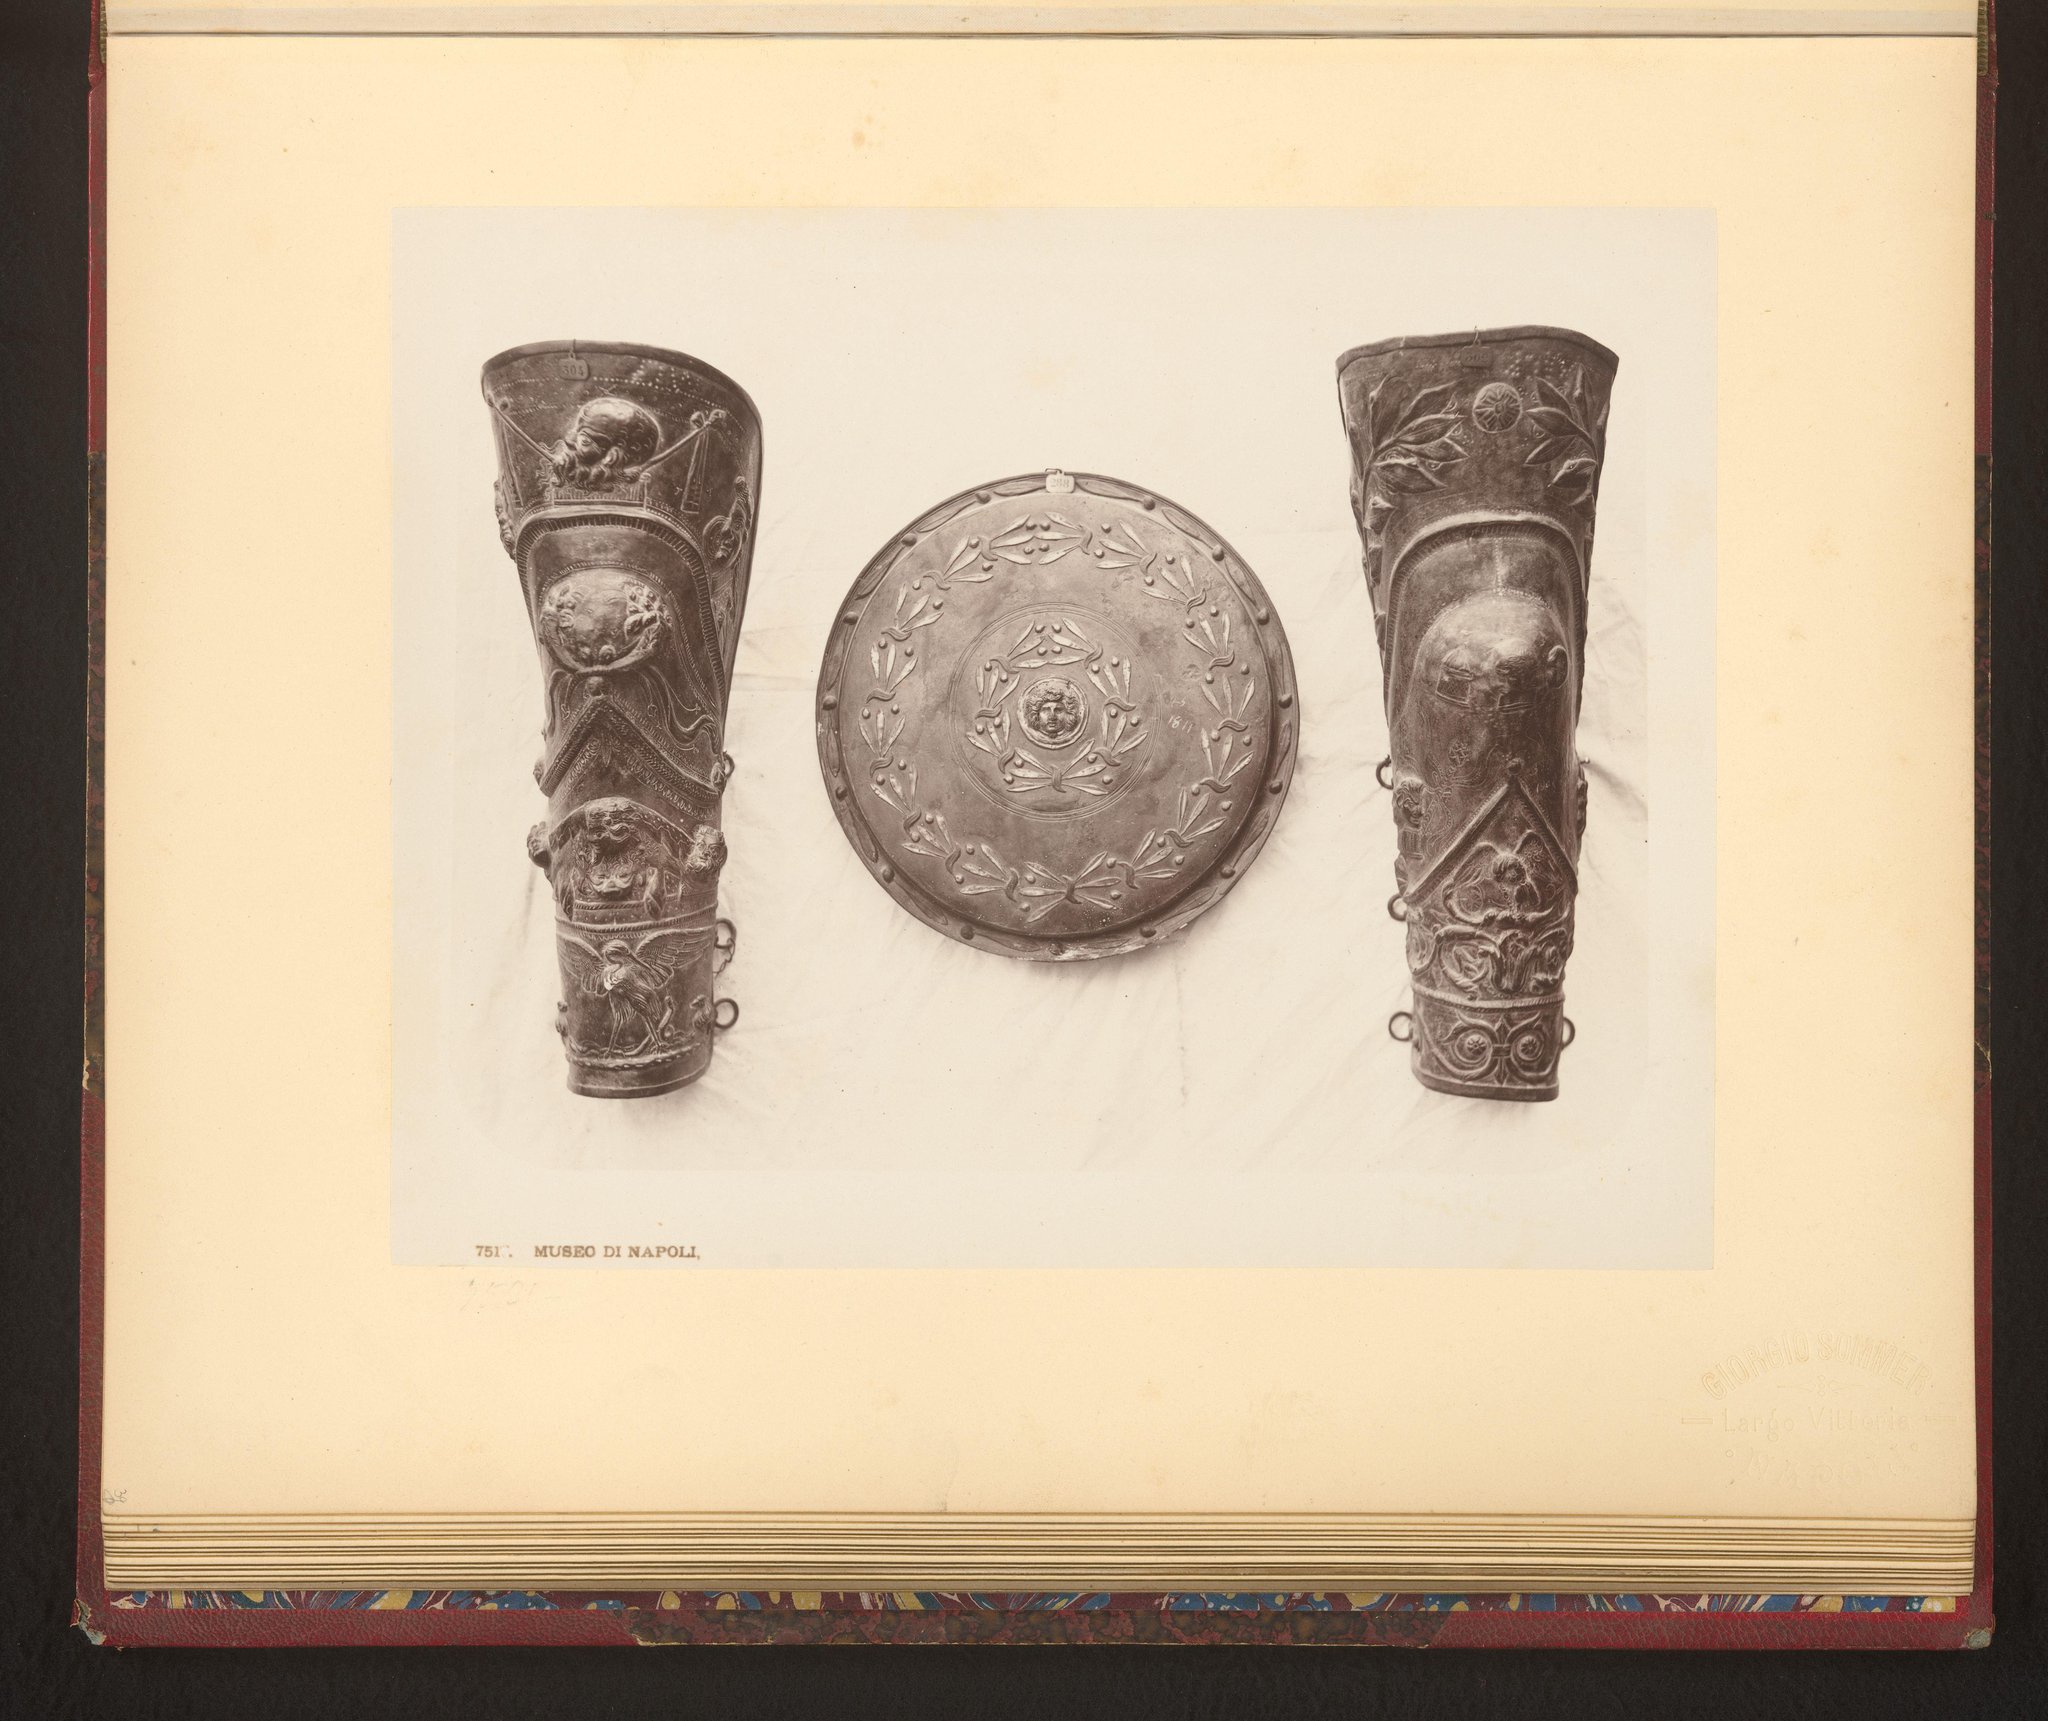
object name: photograph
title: Gedecoreerde objecten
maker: giorgio sommer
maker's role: fotograaf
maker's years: 1834-1914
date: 1874-1879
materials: photographic support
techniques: albumen print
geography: naples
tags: military clothing and other equipment (uniforms, cap, armour, helmet, etc.)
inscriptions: workshop stamp: ‘Giorgio Sommer/ Largo Vittoria/ Napoli’, number: ‘7517’